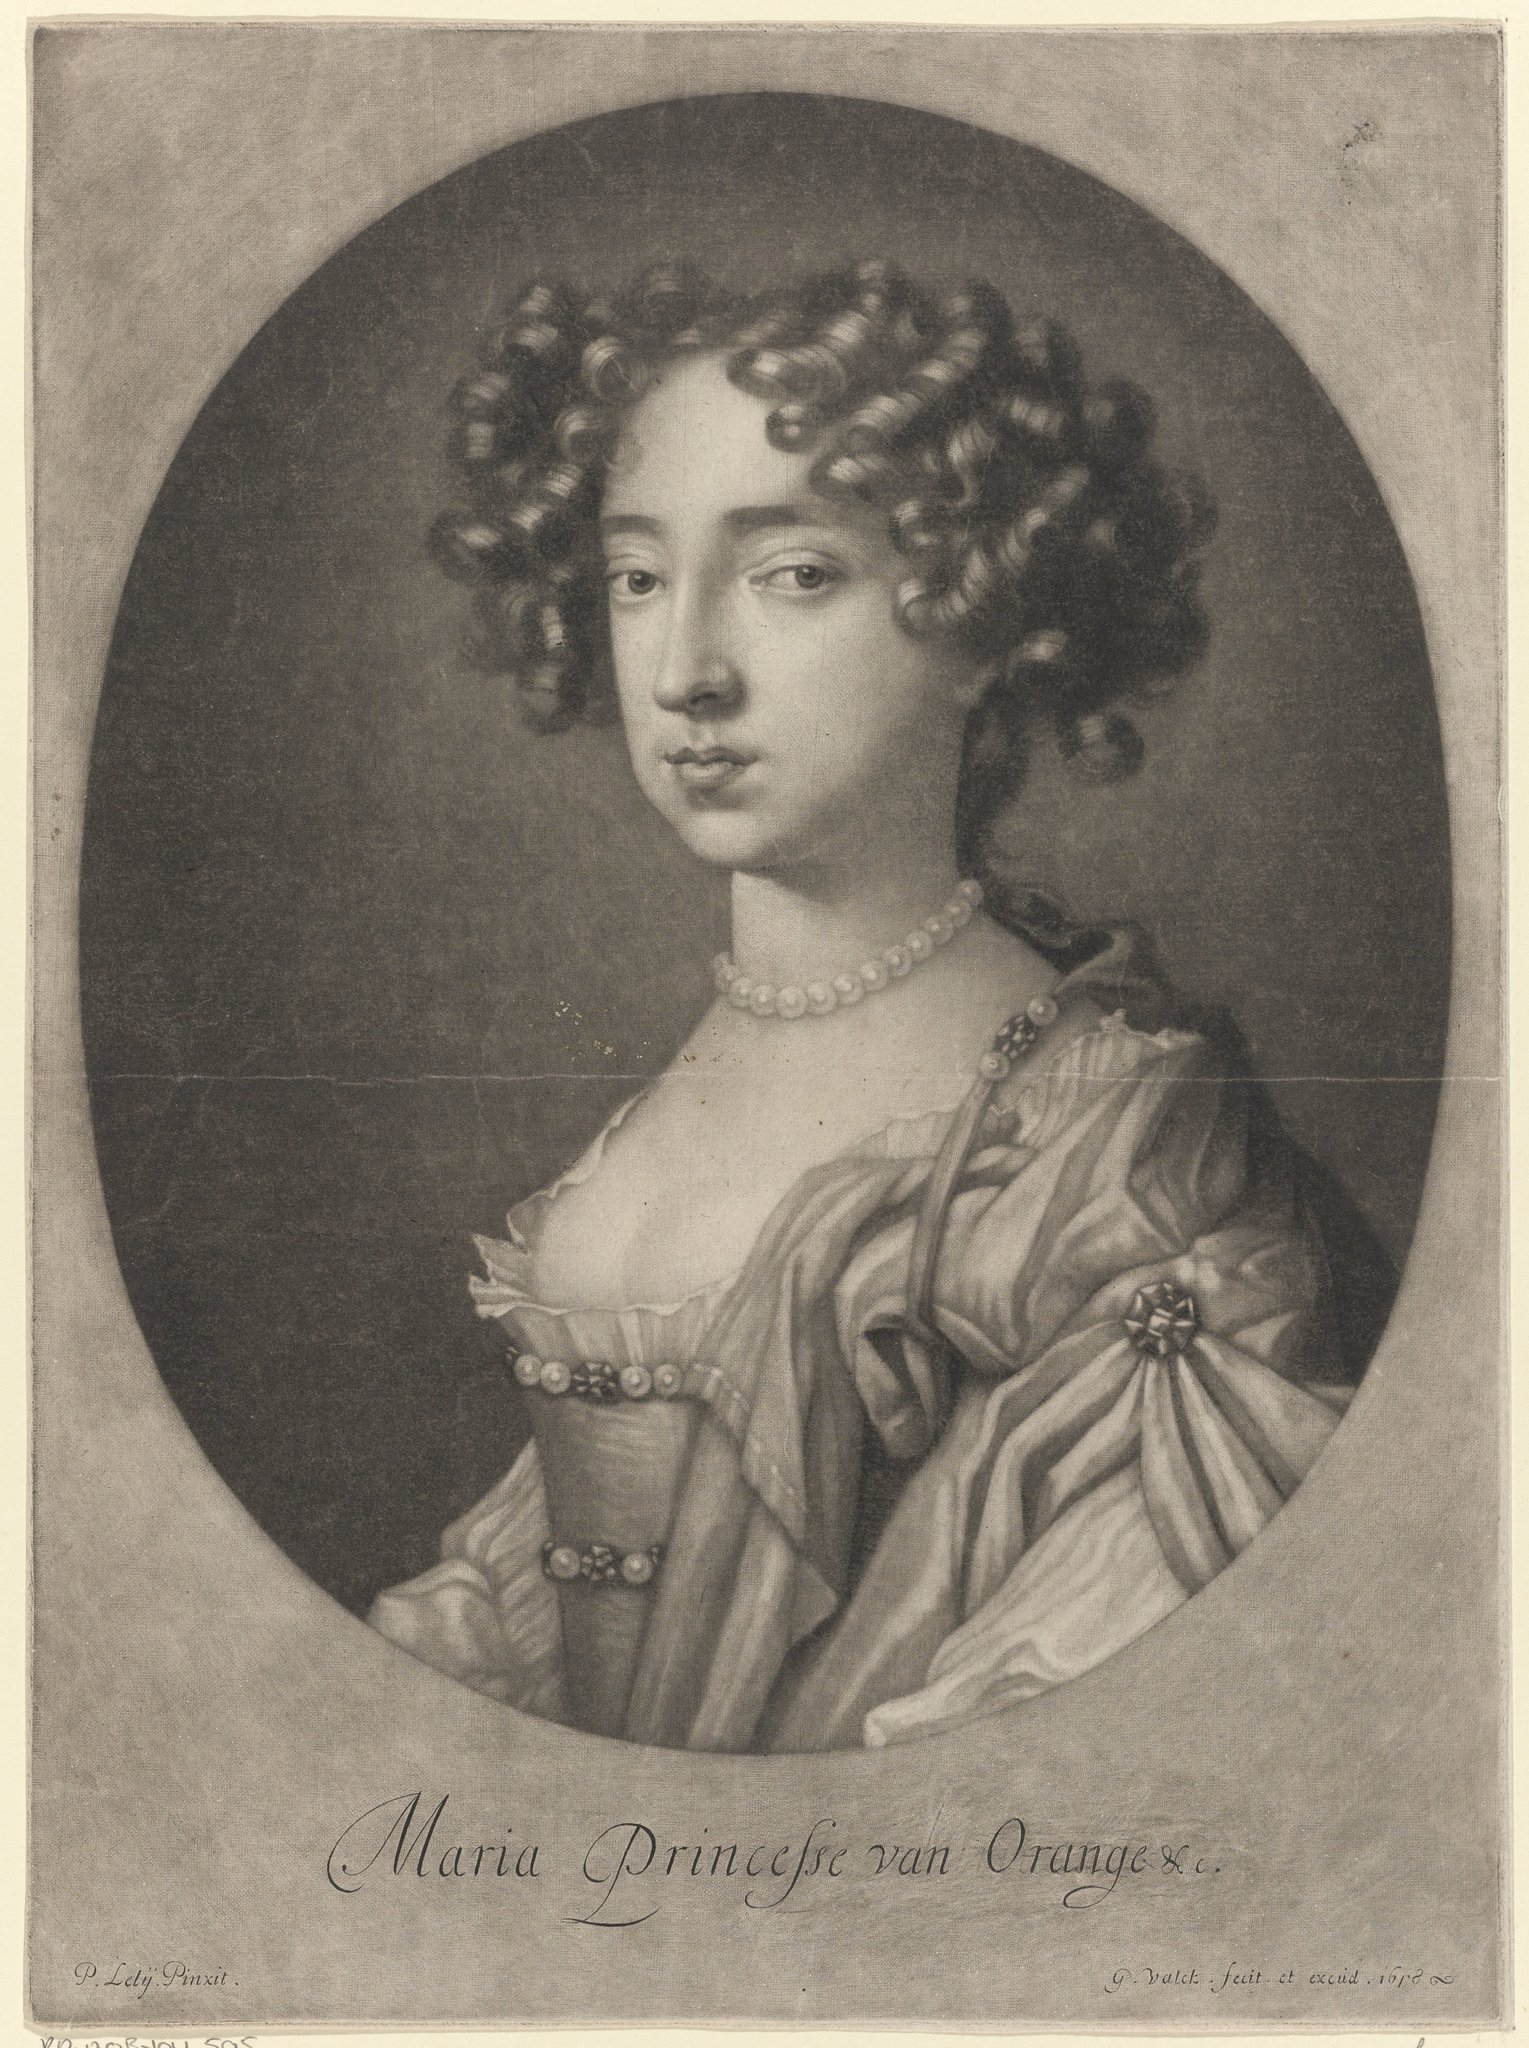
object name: print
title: Portret van Maria II Stuart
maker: peter lely (sir)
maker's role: draughtsman, painter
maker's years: 1618-1680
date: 1678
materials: paper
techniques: mezzotint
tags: london, maria ii stuart (koningin van engeland, schotland en ierland)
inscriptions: collector's mark: Lugt 2228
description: Portret van Maria II in een ovaal. In de ondermarge haar naam en titels.